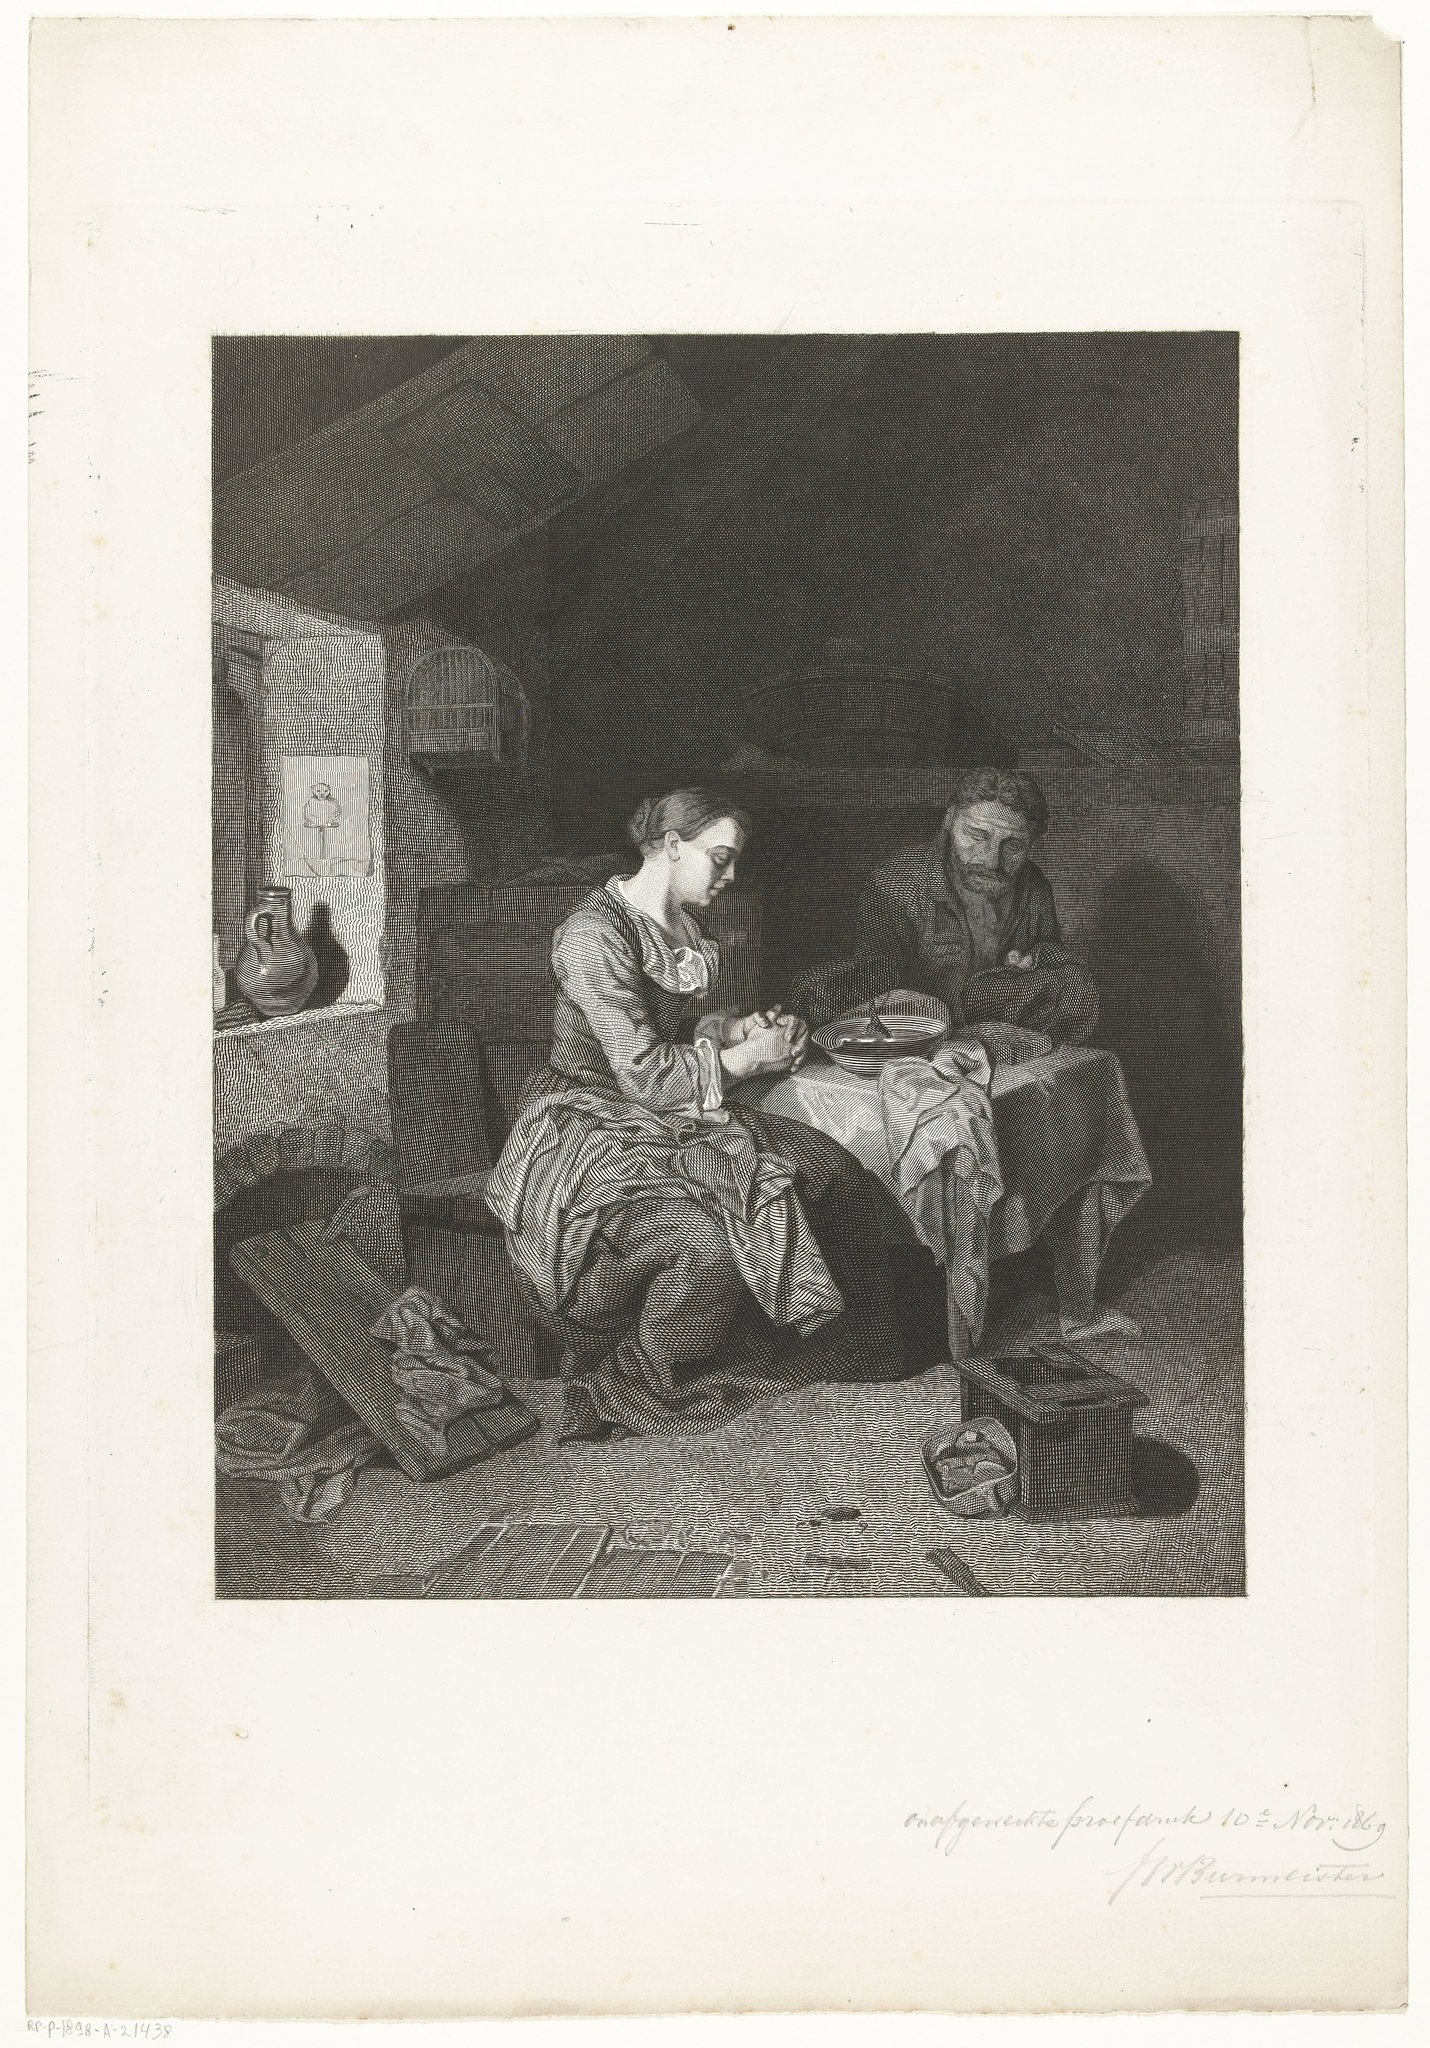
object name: print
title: Gebed voor de maaltijd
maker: friedrich wilhelm burmeister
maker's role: print maker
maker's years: 1845-1933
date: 1855-1898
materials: paper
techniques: engraving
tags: foot-stove, hands folded with fingers knit, kitchen-interior, prayer at table, saying grace, the poor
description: Interieur van een armzalig boerenhuishouden. Een oude man en een jonge vrouw zitten aan tafel. Beiden hebben de ogen gesloten en de handen gevouwen in gebed. Op de tafel staat een groot bord soep of pap, een homp brood en wat boter. De kamer is wanordelijk. Op de grond liggen een gebroken bankje en een gebroken vuurpot. Op de vensterbank een kruik en een prent van een aapje.